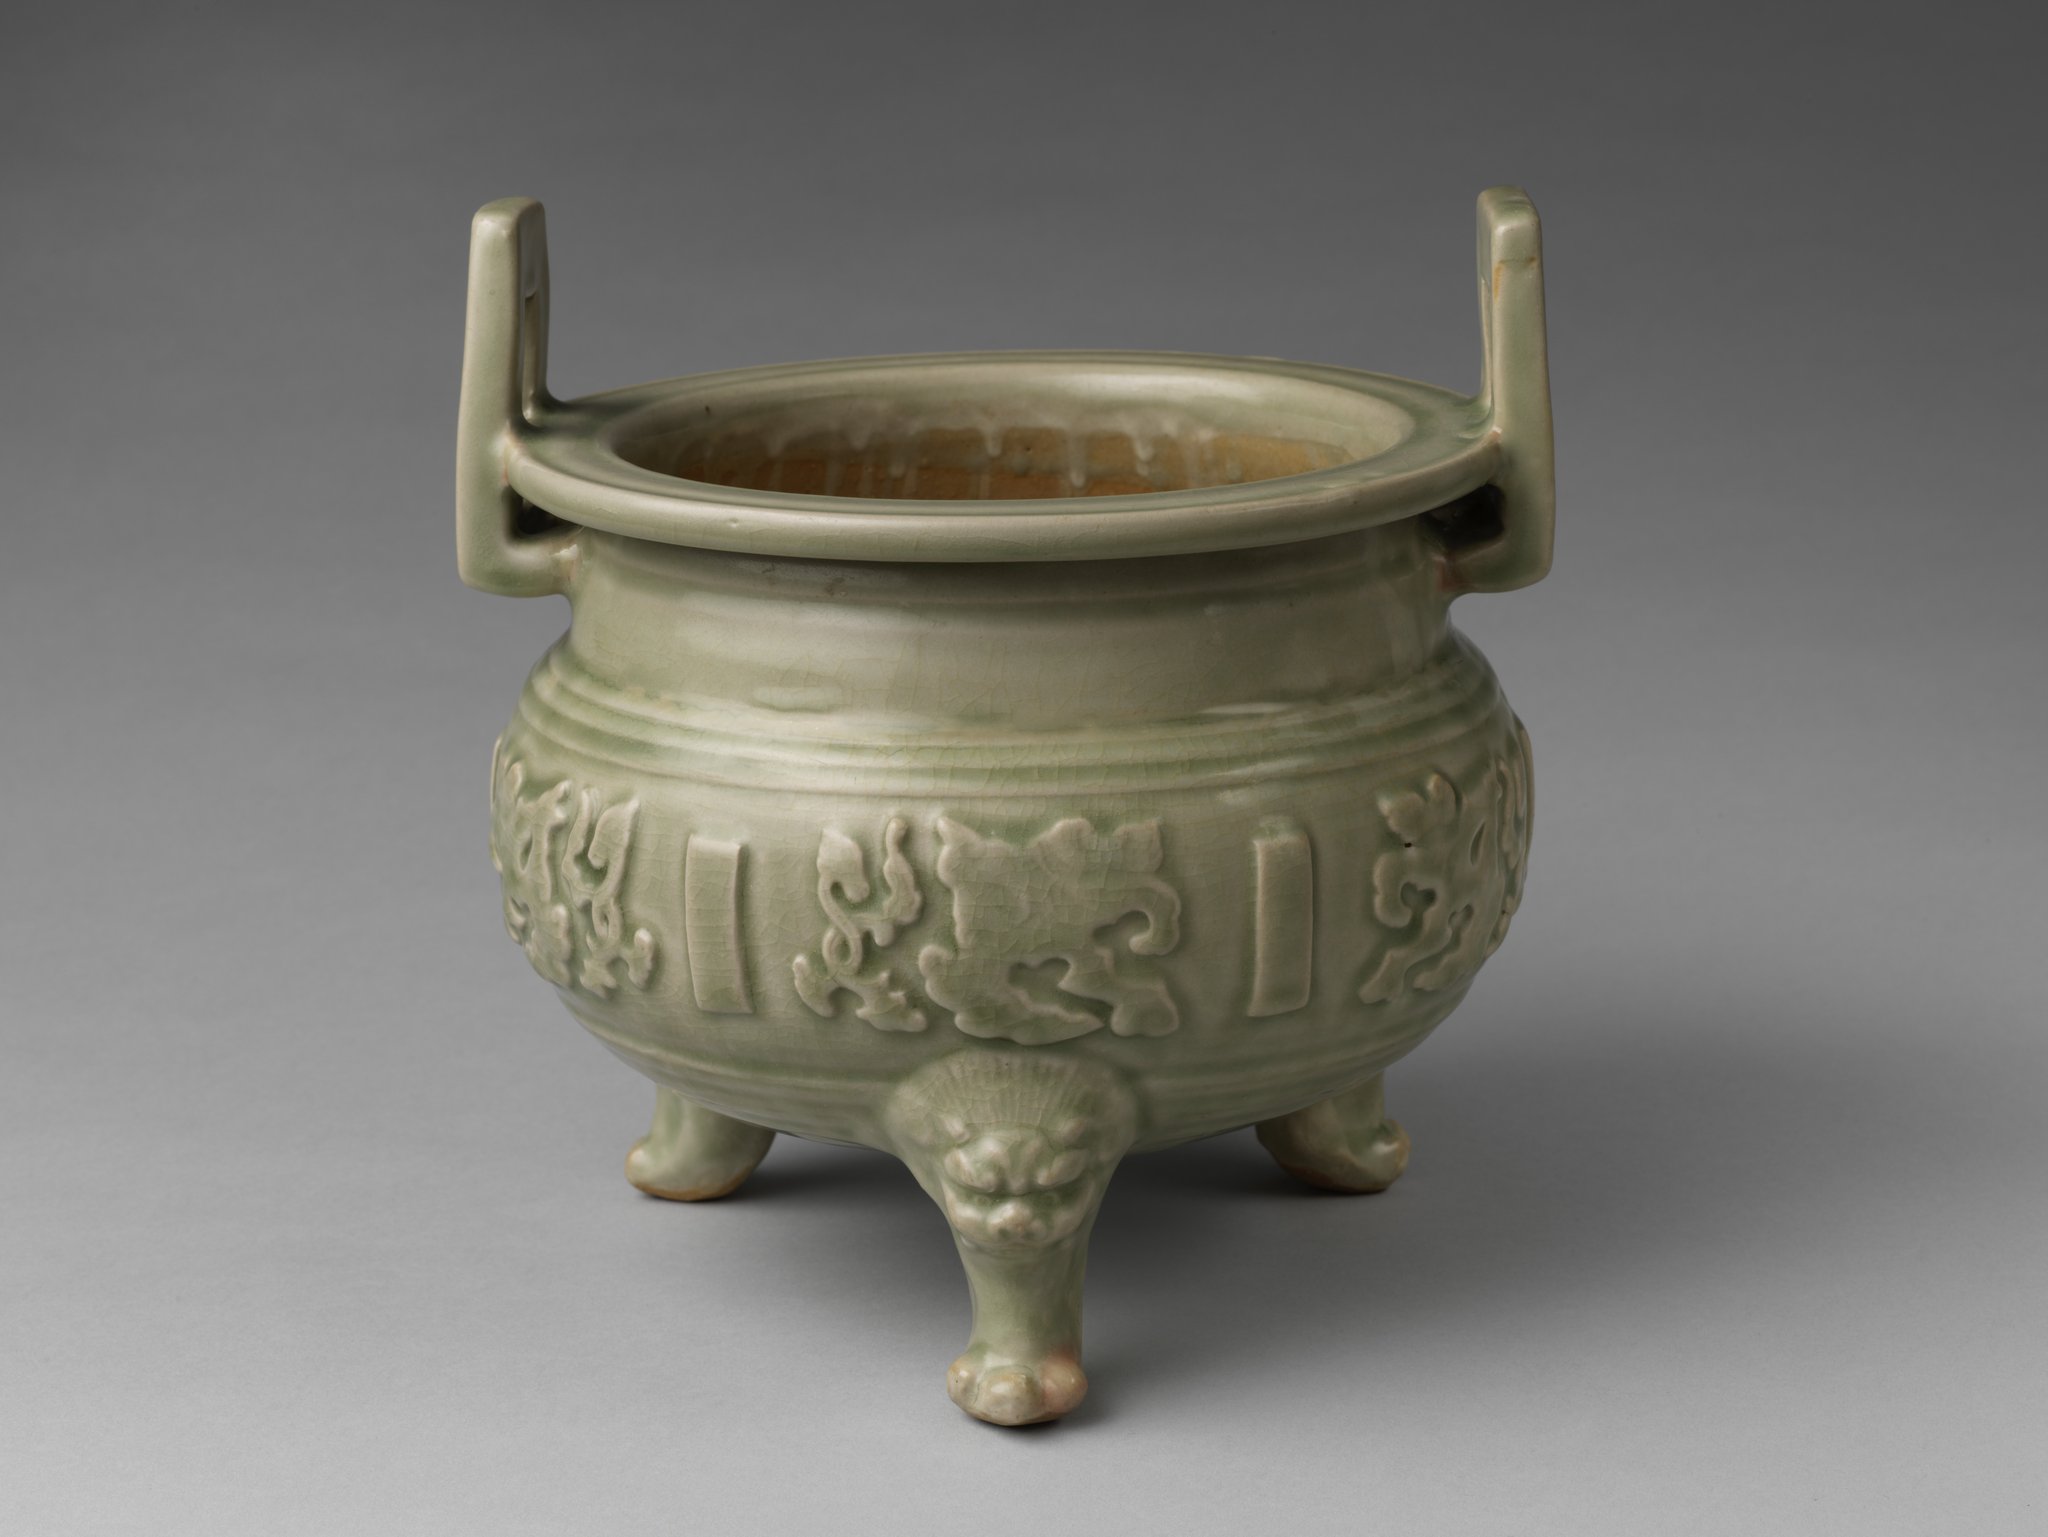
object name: incense burner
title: Tripod incense burner with archaistic patterns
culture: chinese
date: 1101-1200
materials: ceramic glaze, glaze, stoneware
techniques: molding